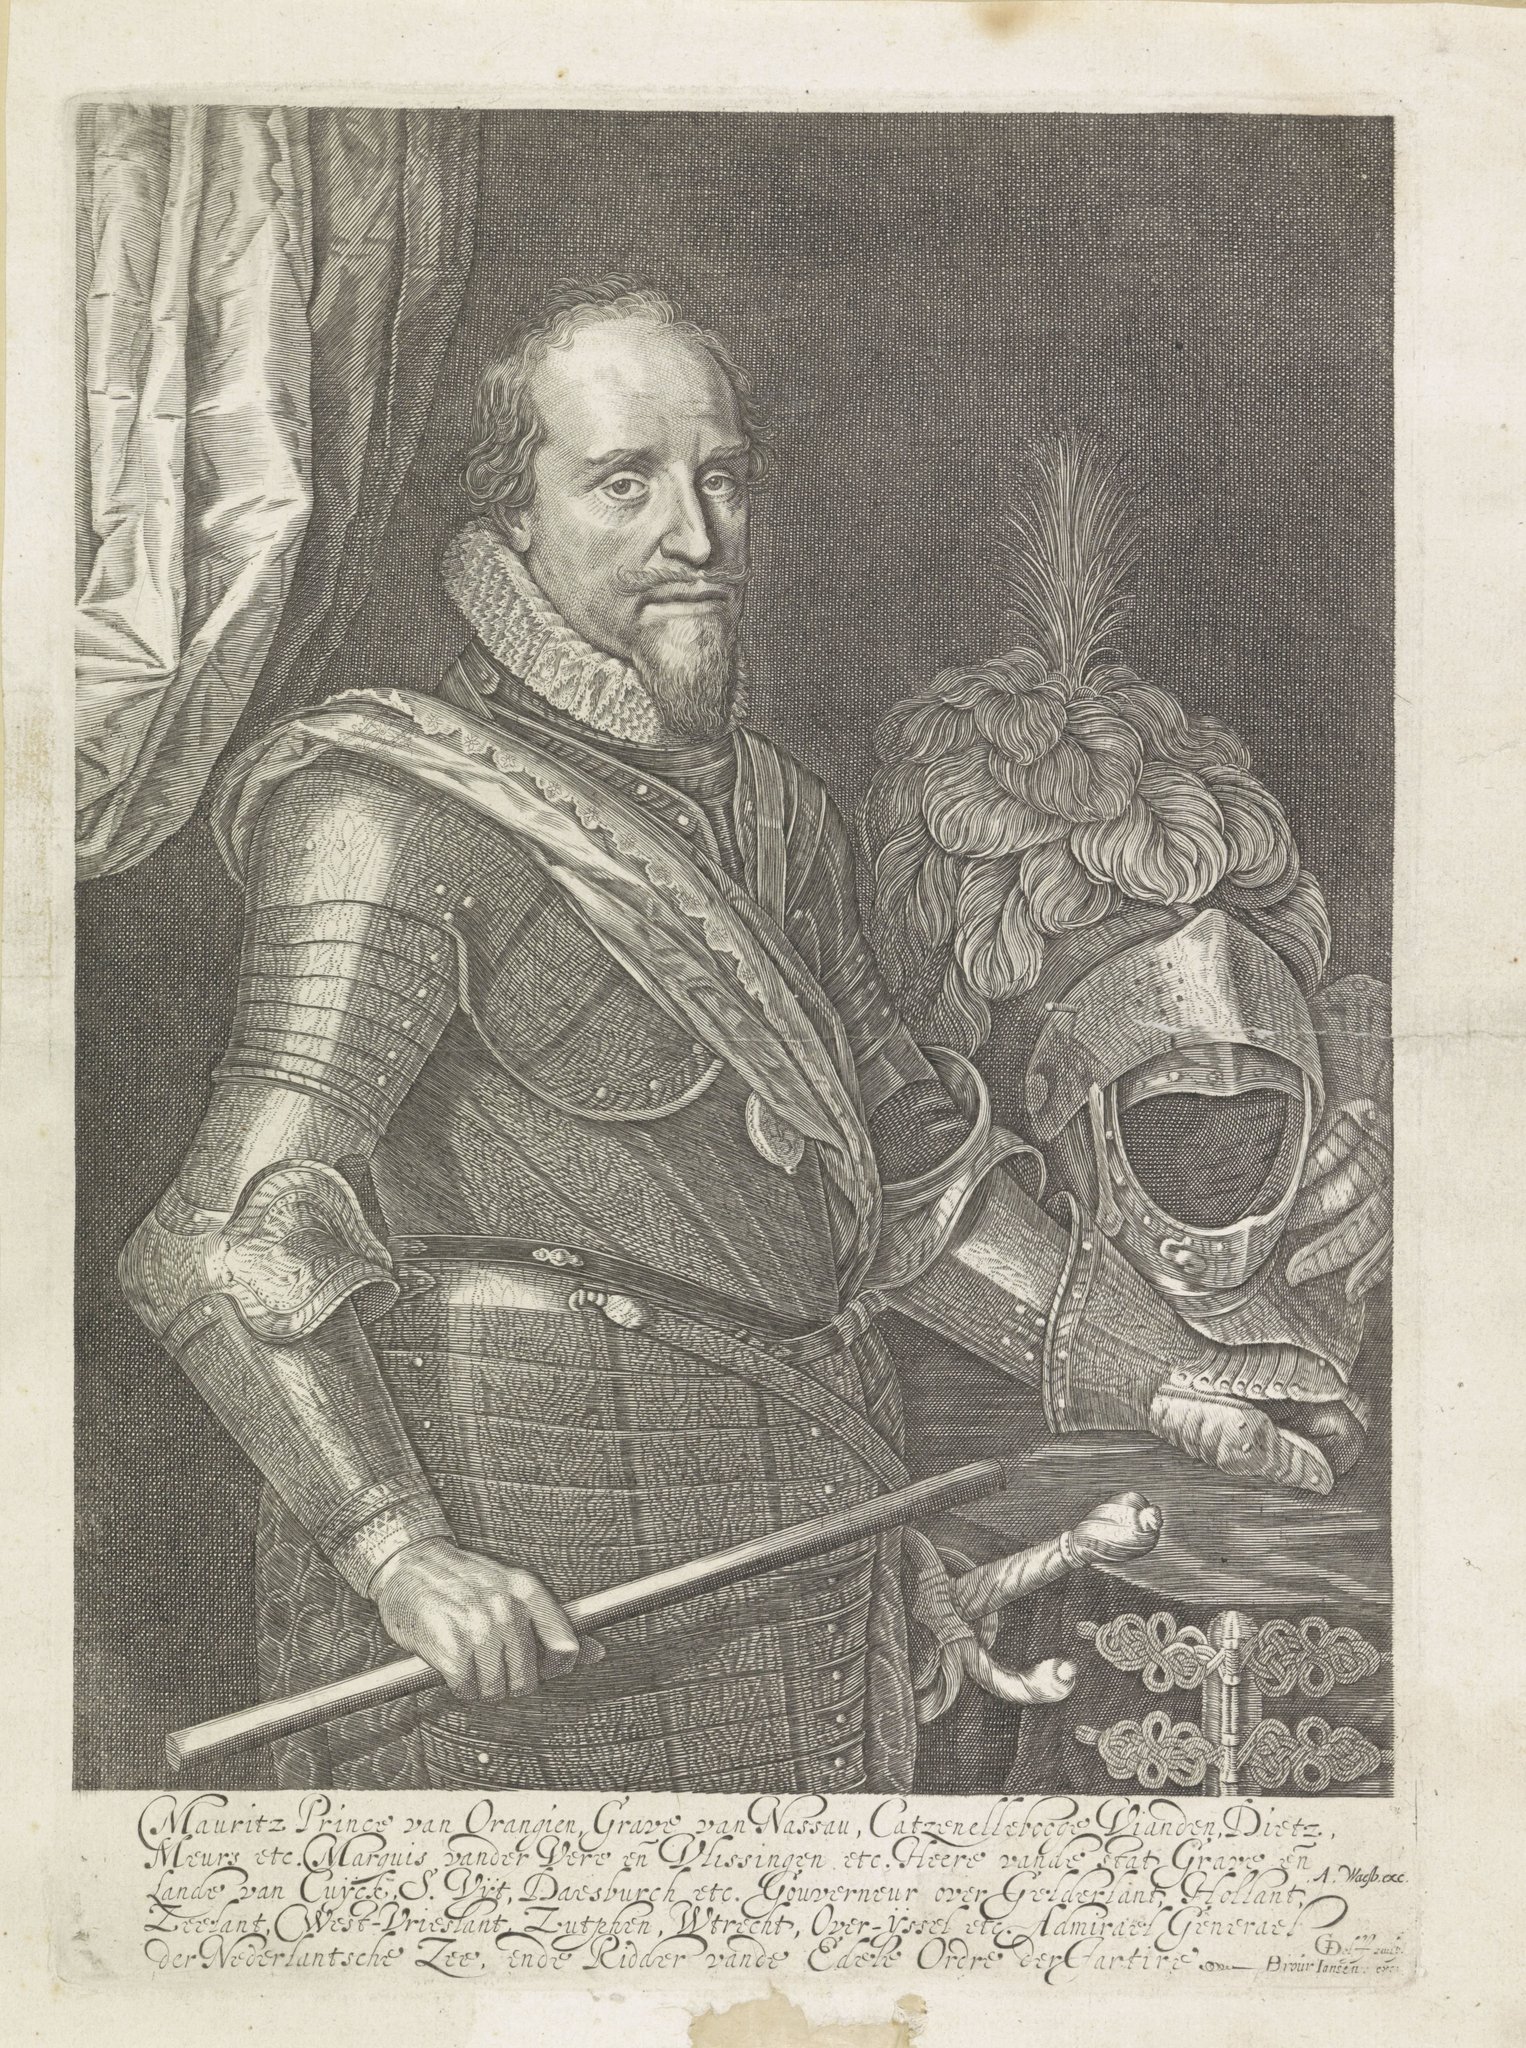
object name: print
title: Portret van Maurits, prins van Oranje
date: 1632-1644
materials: paper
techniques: engraving, etching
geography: amsterdam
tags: the hague, maurice (prince of orange), knighthood order (garter) - insignia of a knighthood order, e.g.: badge, chain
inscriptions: collector's mark: Lugt 964, collector's mark: Lugt 963, collector's mark: Lugt 698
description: Portret van Maurits. Hij staat naast een tafel met daarop de helm van zijn harnas. Hij houdt een commandostaf in de hand. In de ondermarge vijf regels Nederlandse tekst.